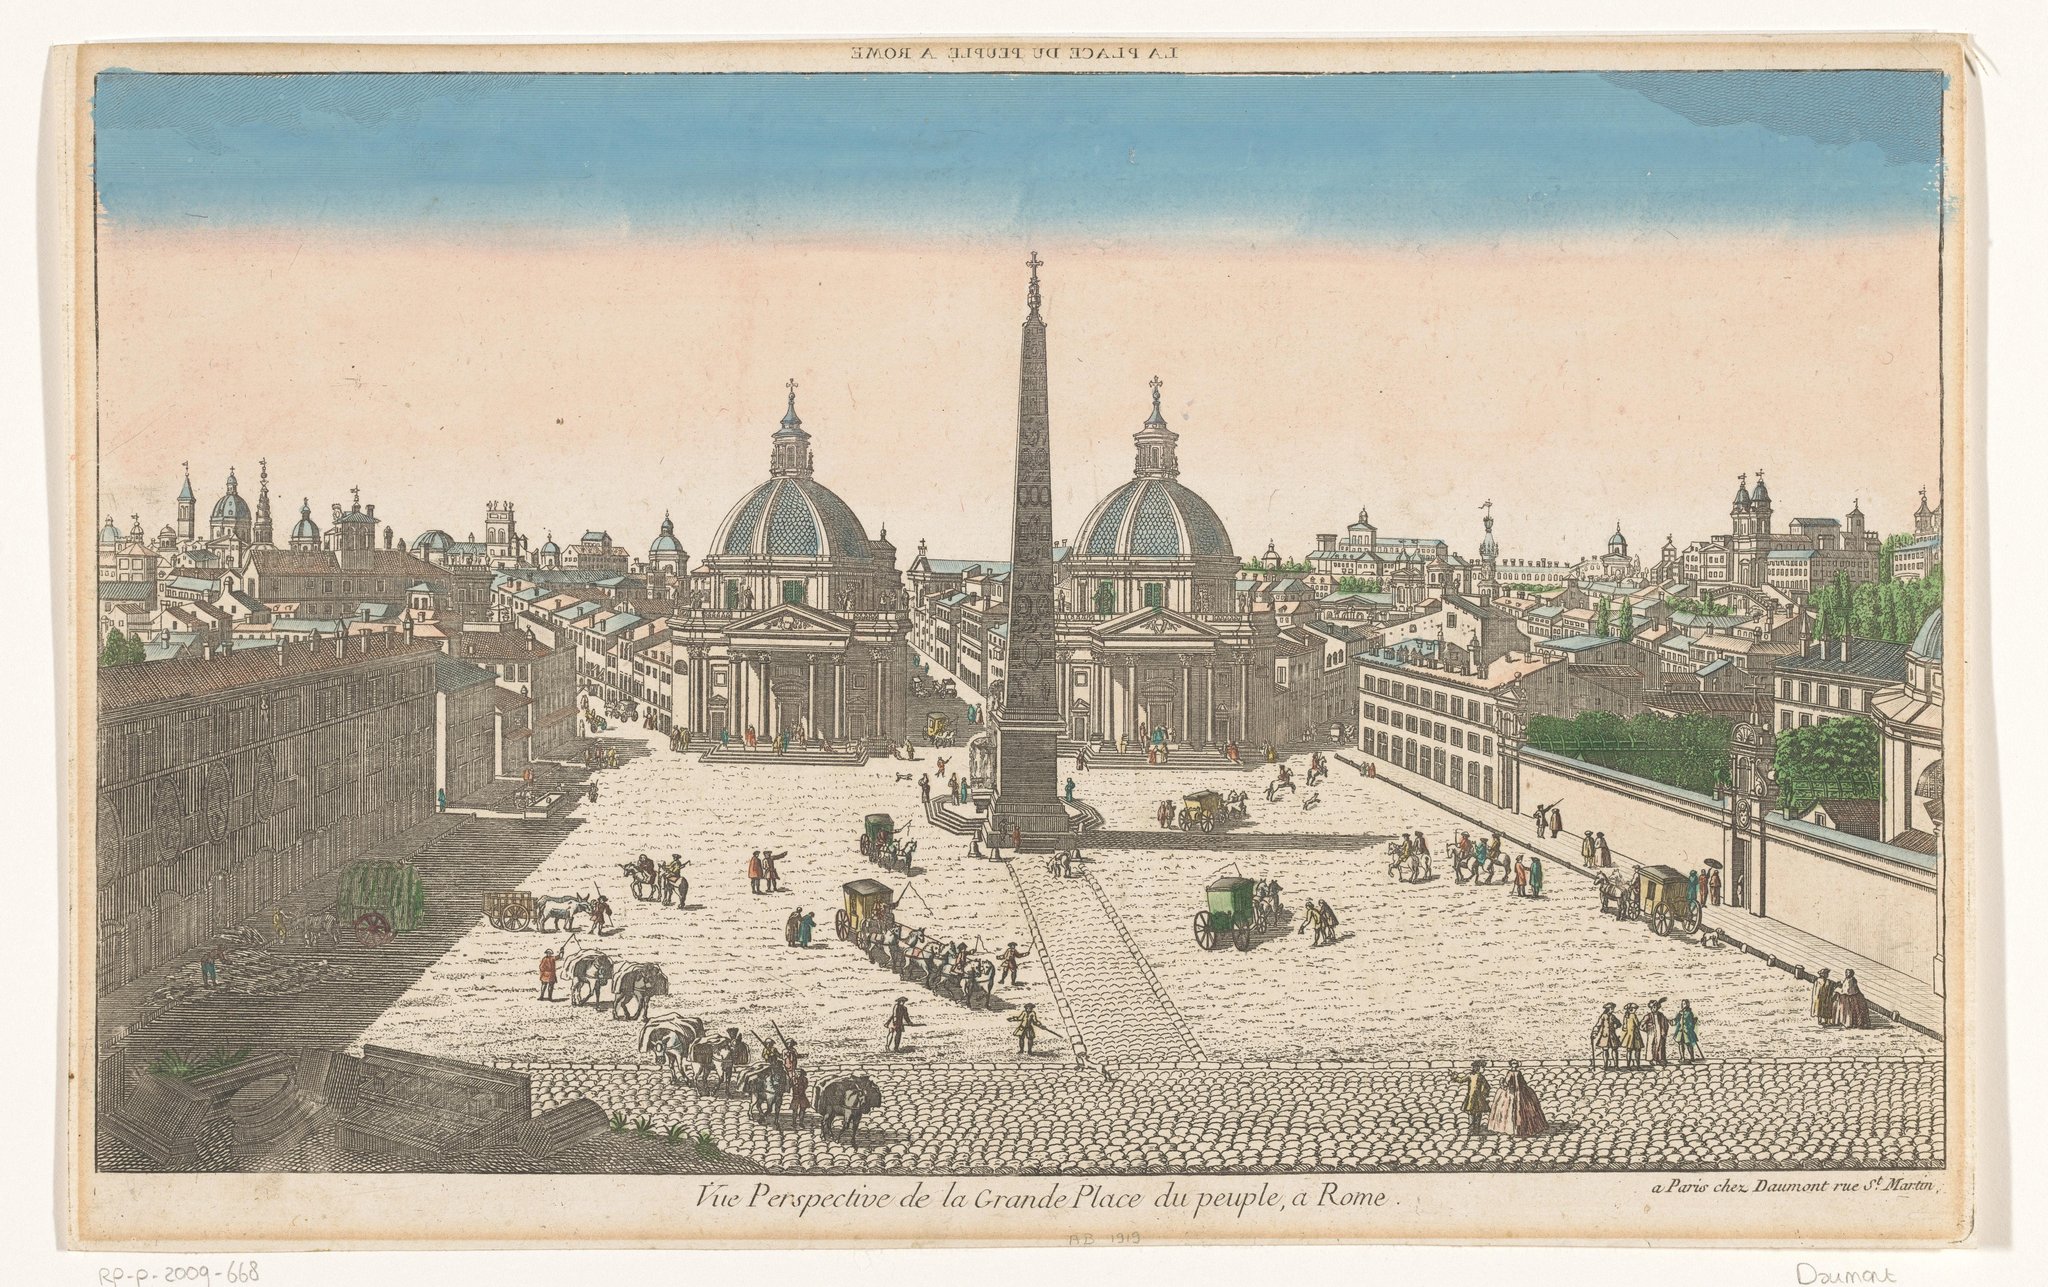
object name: print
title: Gezicht op het Piazza del Popolo te Rome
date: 1745-1775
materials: paper, watercolor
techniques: brush, etching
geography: france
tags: obelisk, needle (+ city(-scape) with figures, staffage), church (exterior), square, place, circus, etc. (+ city(-scape) with figures, staffage), ornamental fountain (+ city(-scape) with figures, staffage)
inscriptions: watermark, collector's mark: Lugt 2228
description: Gezicht op het plein Piazza del Popolo met in het midden de Egyptische obelisk en daarachter de vrijwel identieke kerken, de Santa Maria dei Miracoli en de Santa Maria in Montesanto